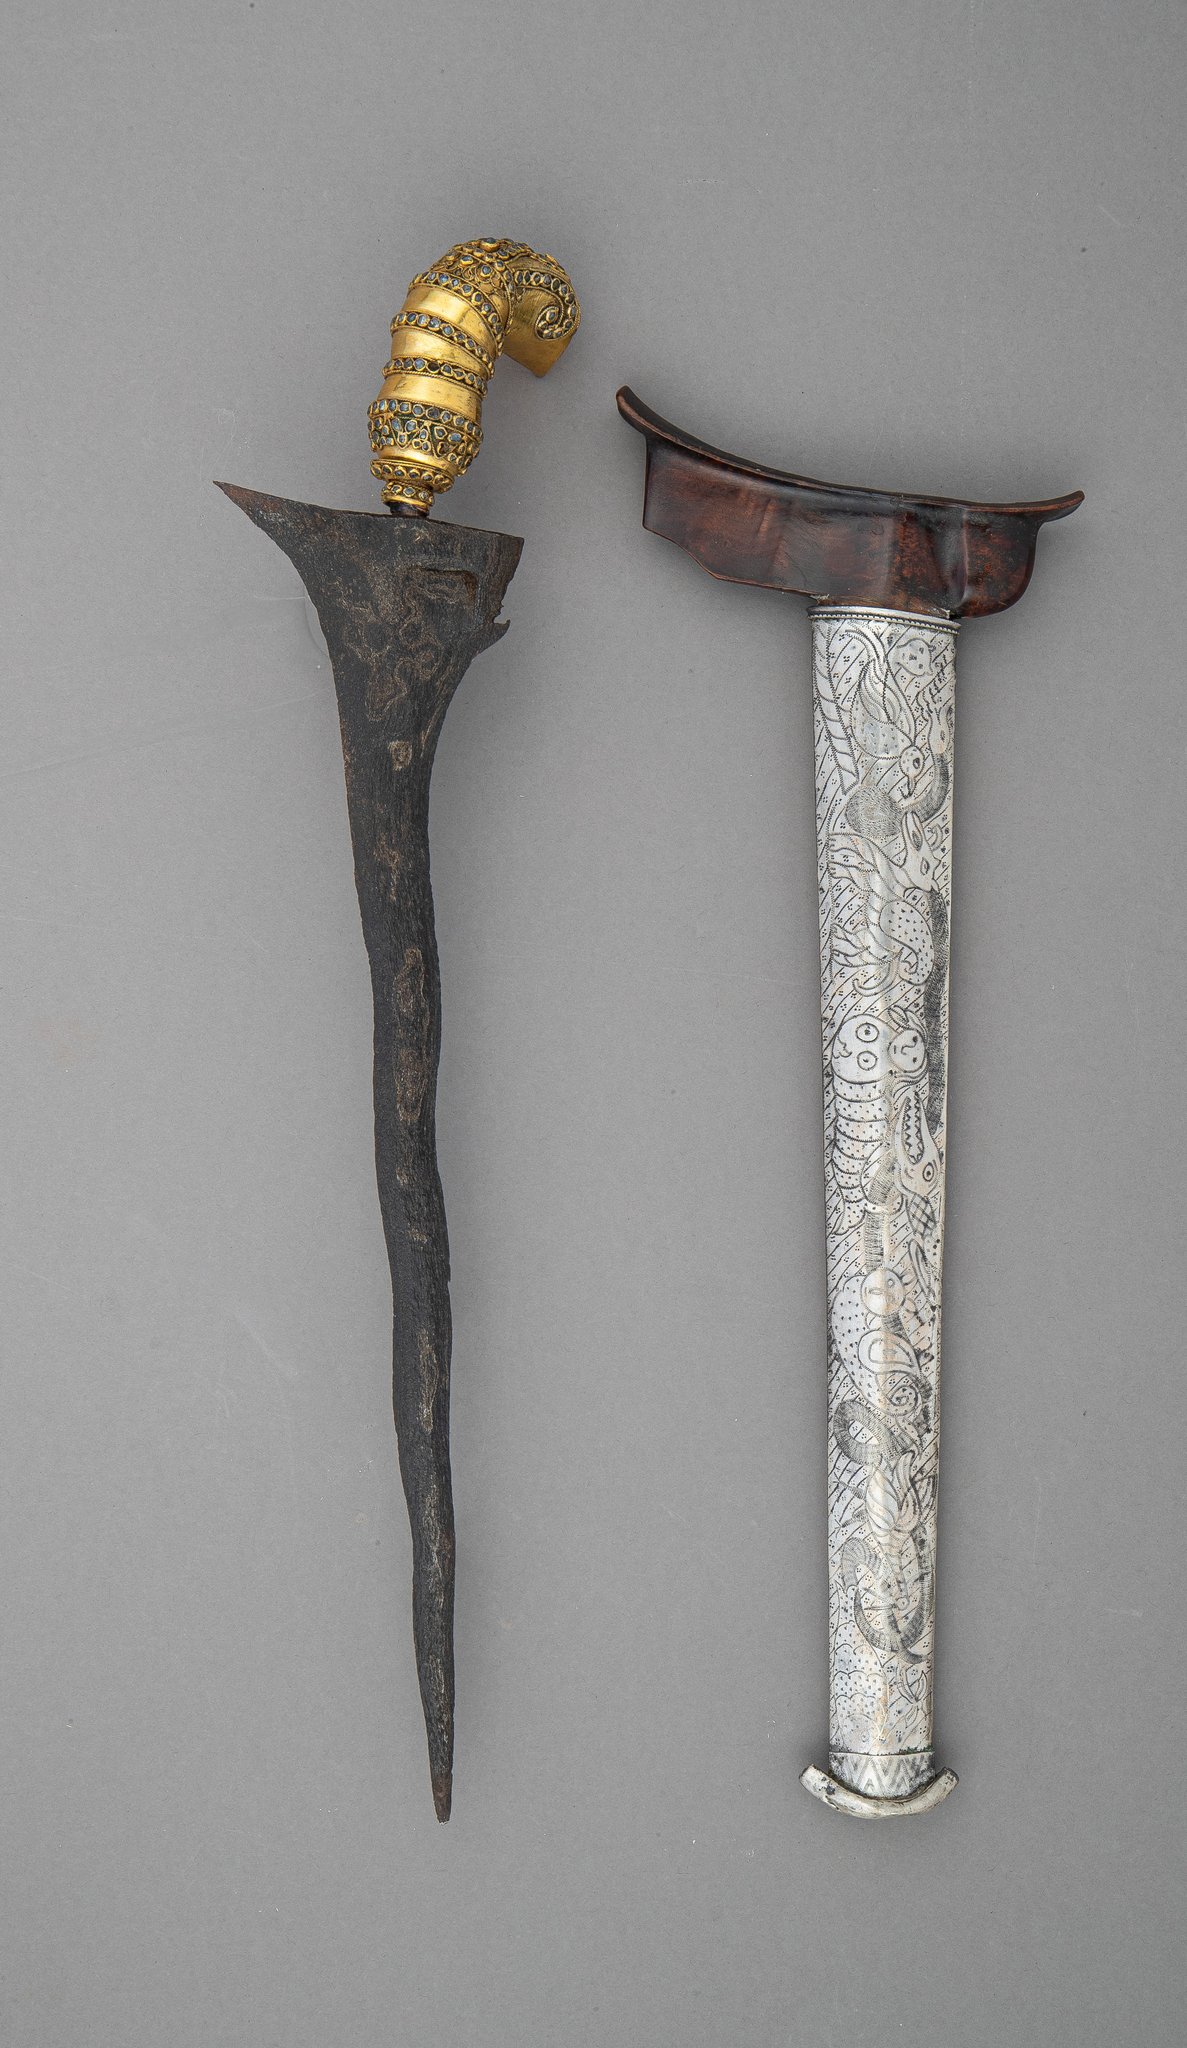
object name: kris with sheath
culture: indonesian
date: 1801-1900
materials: diamond, gold, silver, steel, wood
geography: indonesia